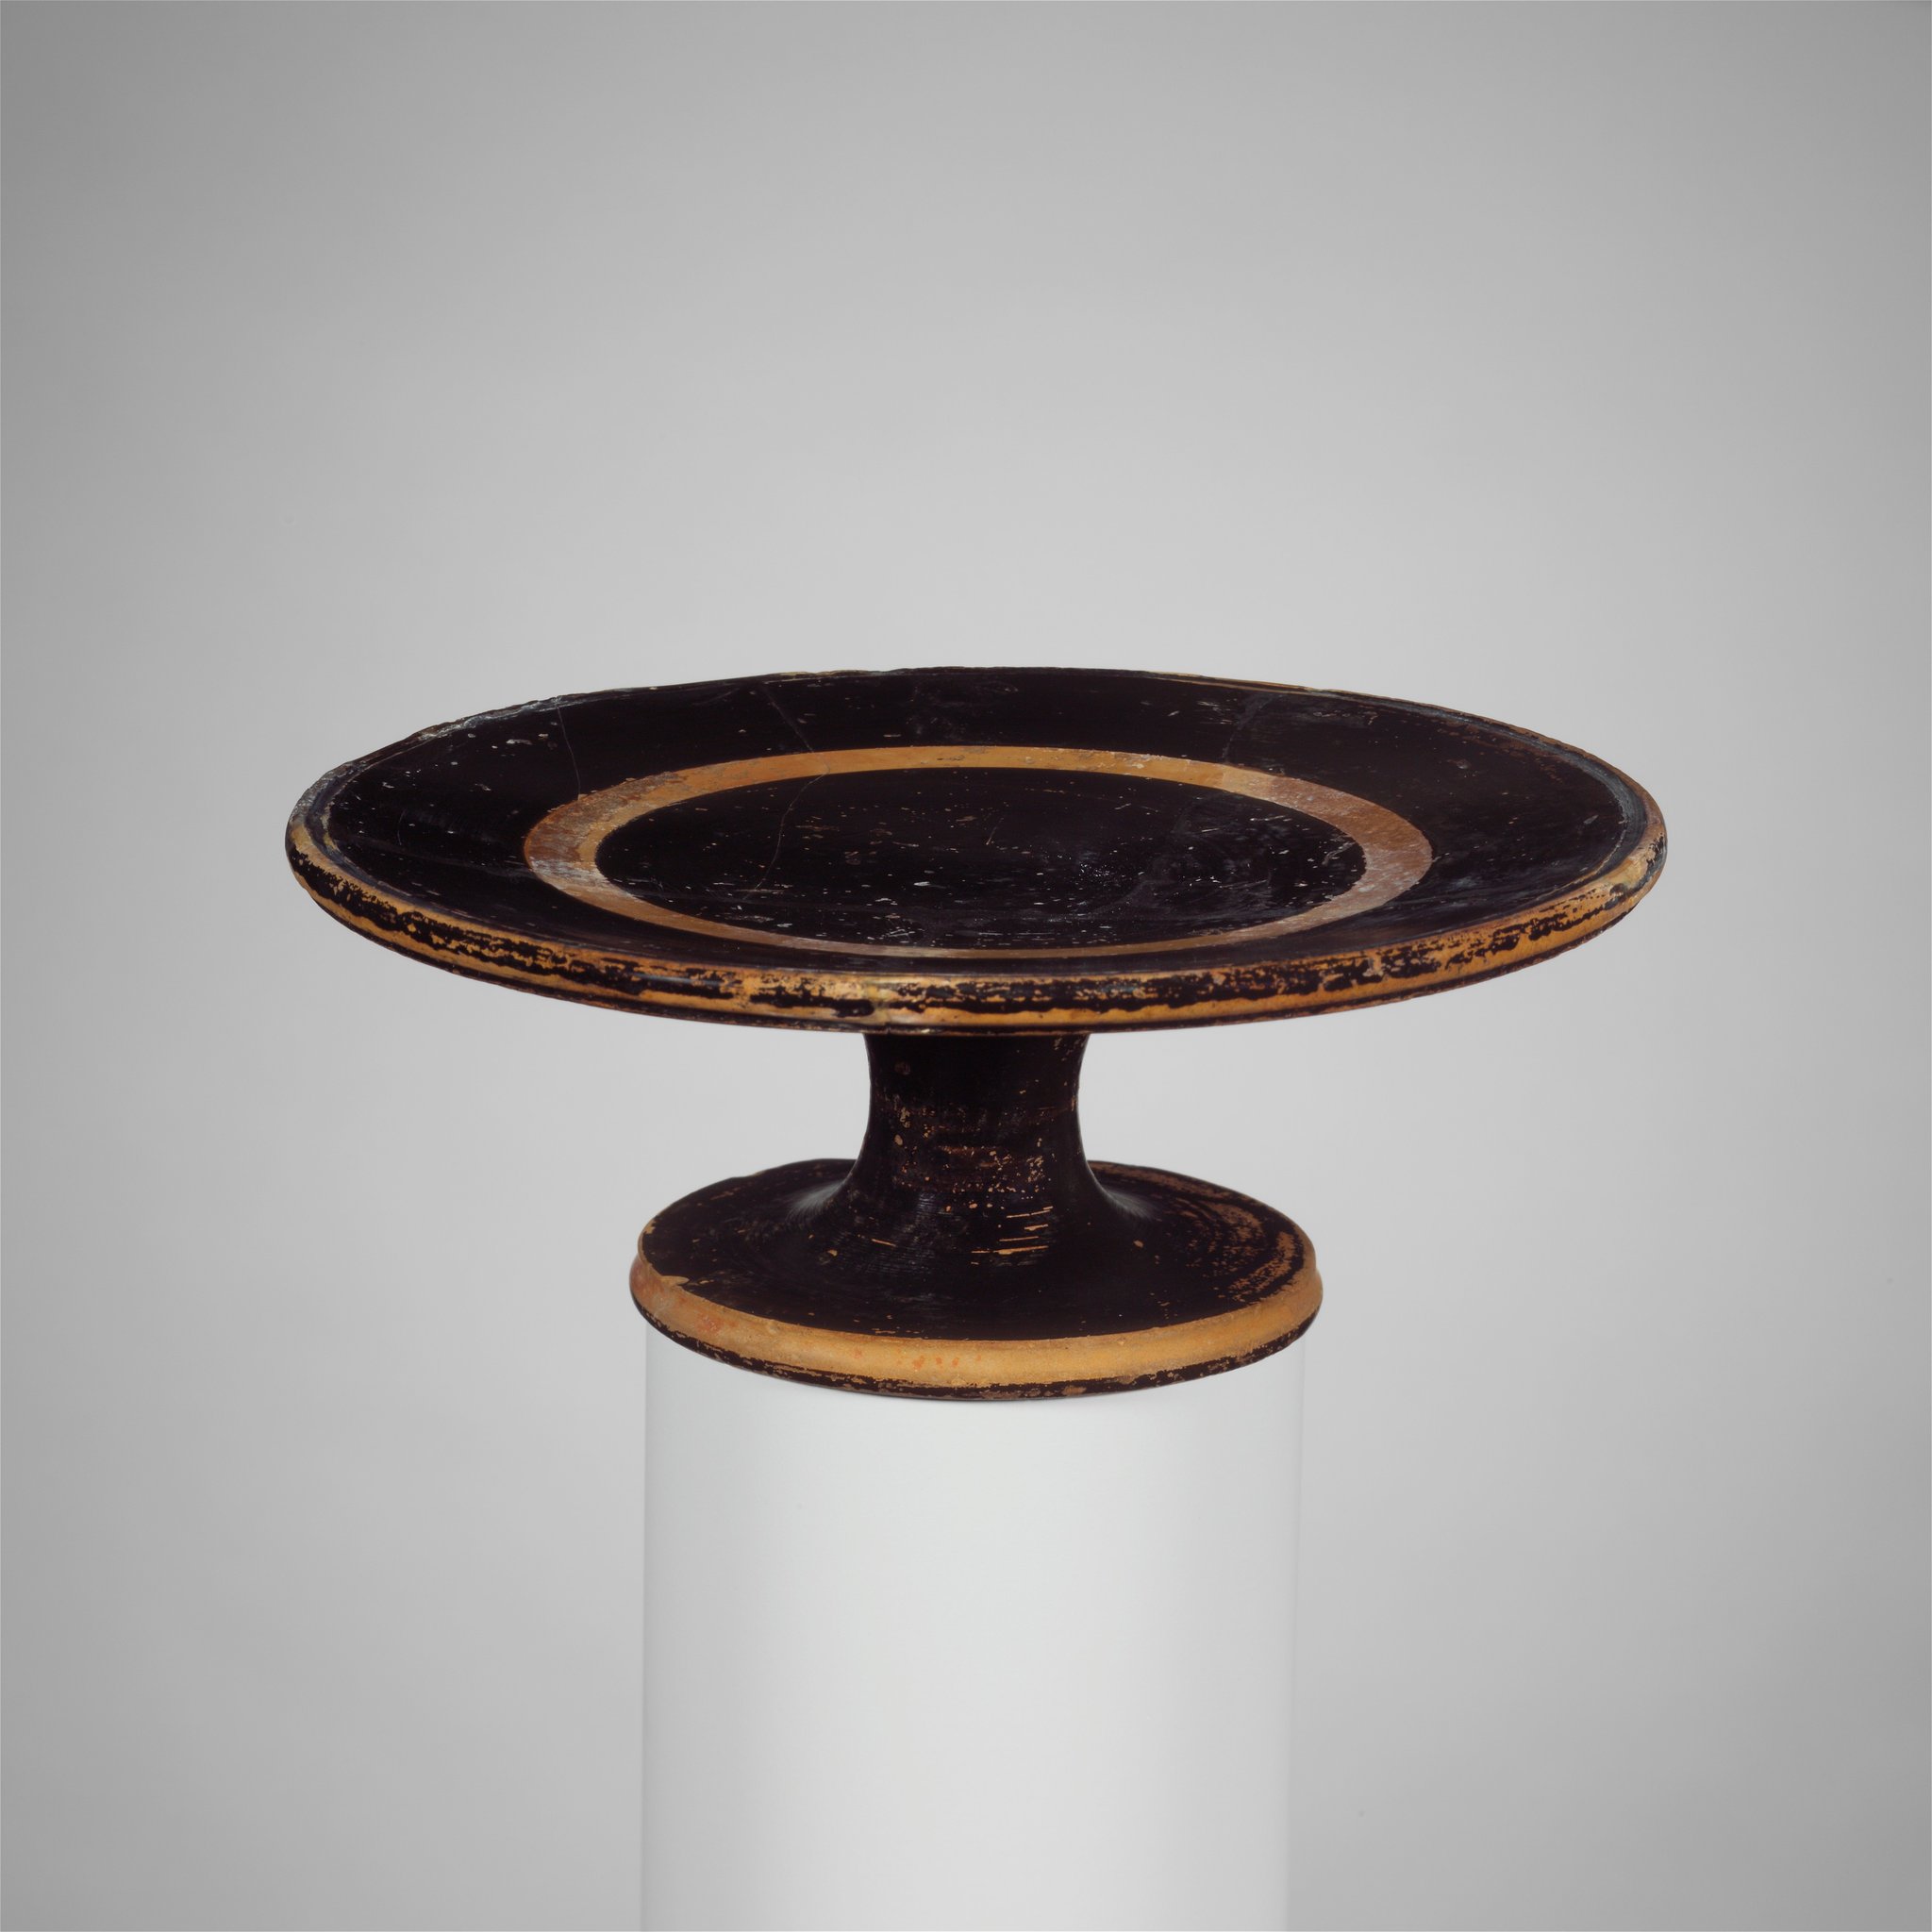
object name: plate, stemmed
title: Terracotta stemmed plate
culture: greek, attic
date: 500-401 BCE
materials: terracotta